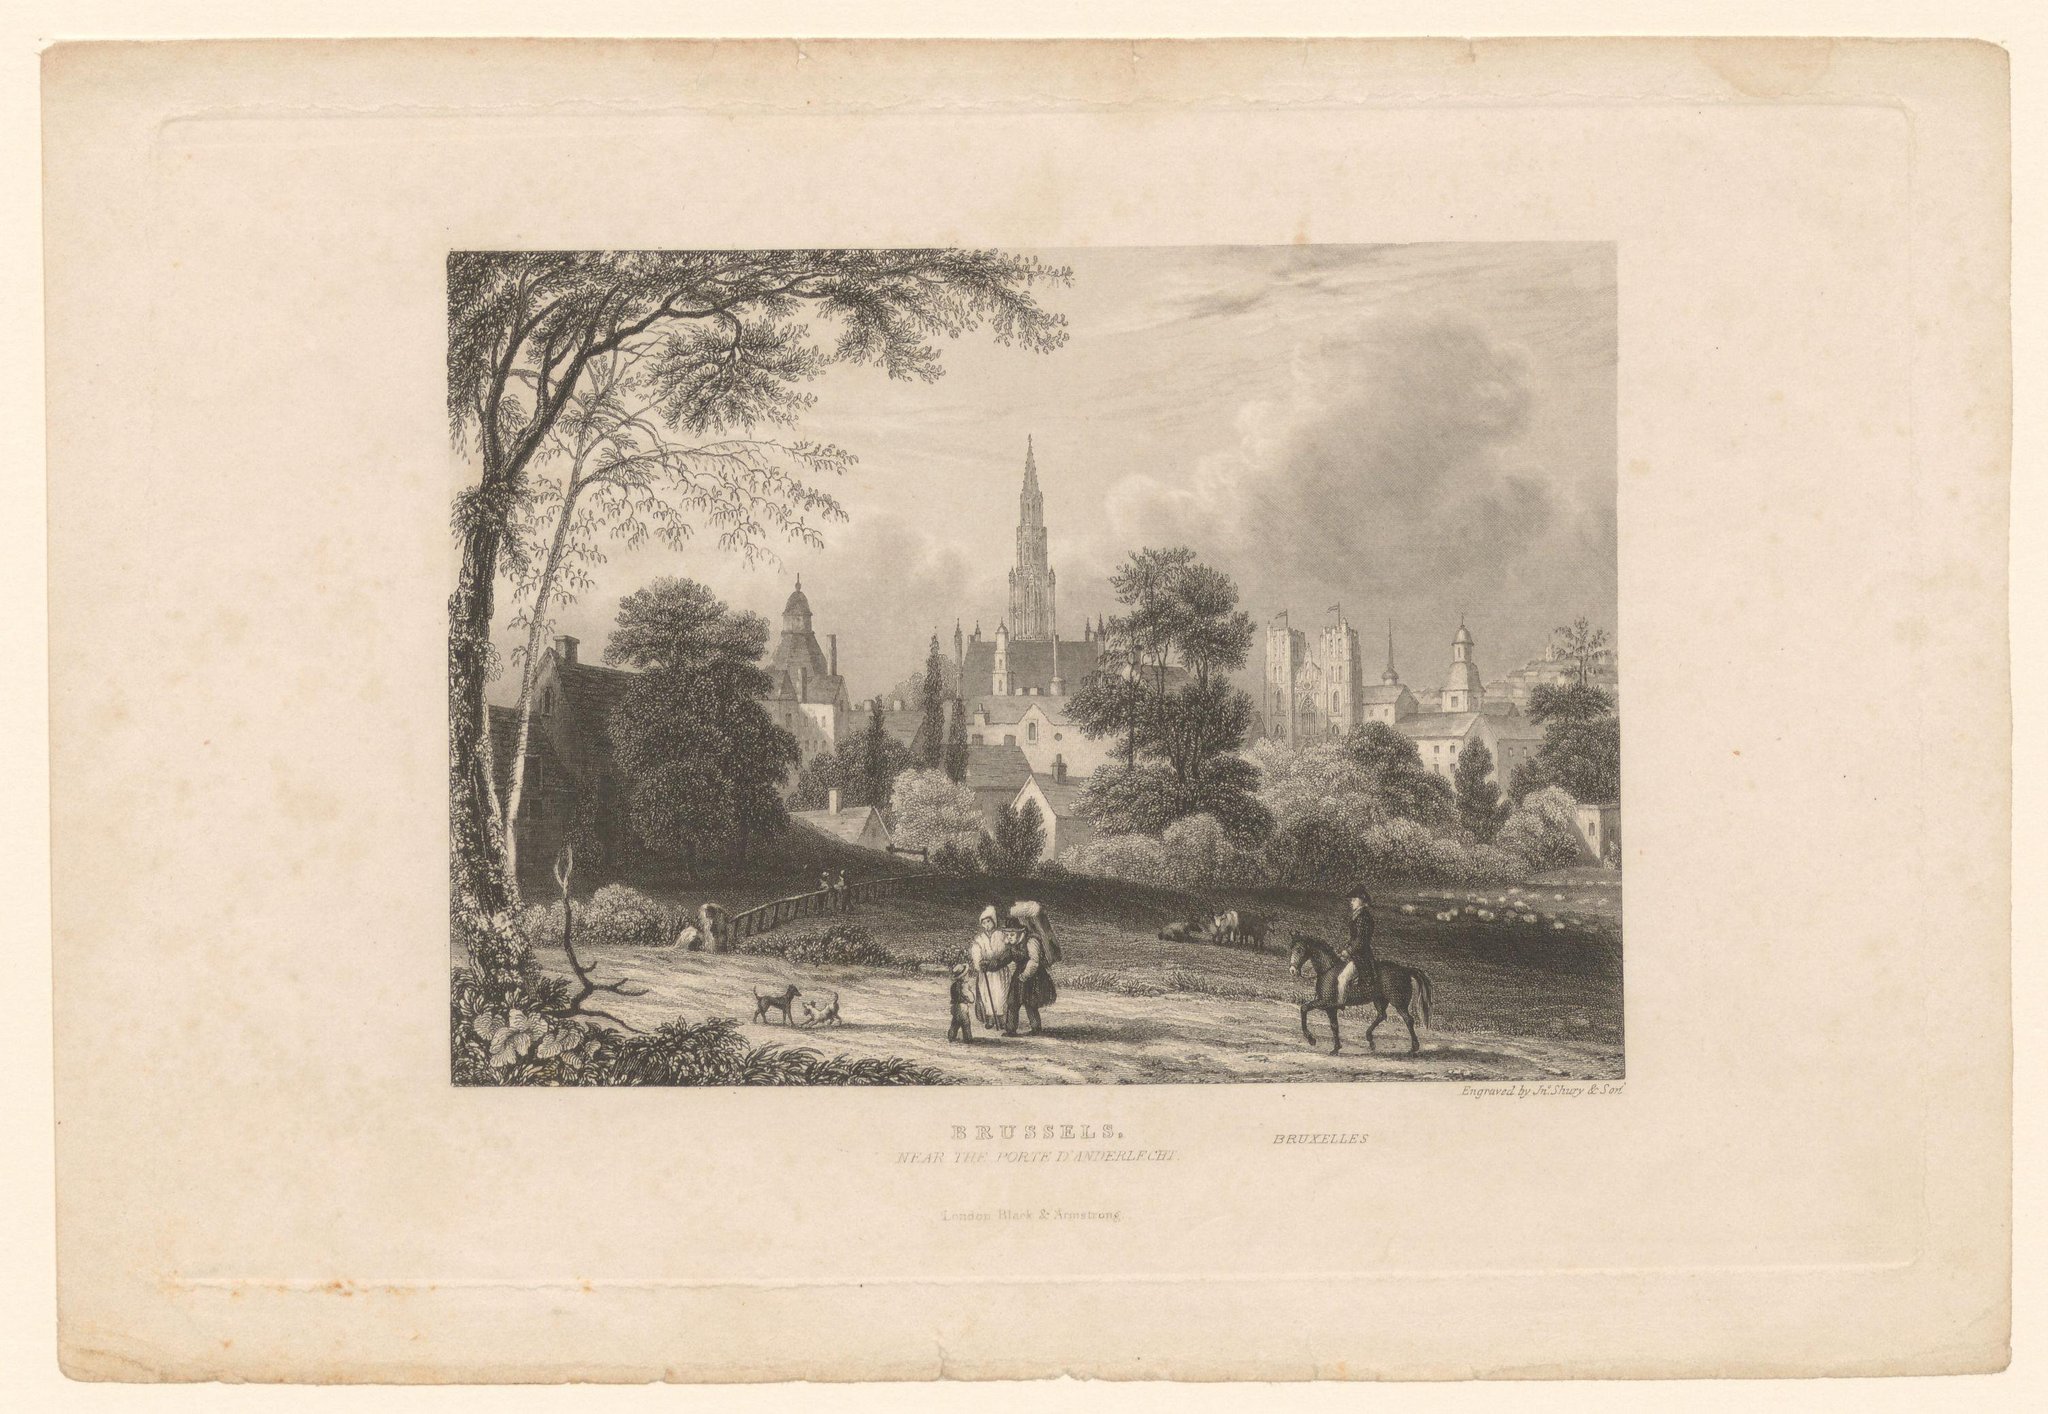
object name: print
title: Brussels, near the Porte d'Anderlecht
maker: john shury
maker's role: print maker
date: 1838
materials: paper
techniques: etching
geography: london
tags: city-view in general; 'veduta', church (exterior), townhall, tower (of house or building)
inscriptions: collector's mark: Lugt 2233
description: Prent uit: Belgium and Nassau; or, The continental Tourist. Londen: Black & Armstrong, 1838.